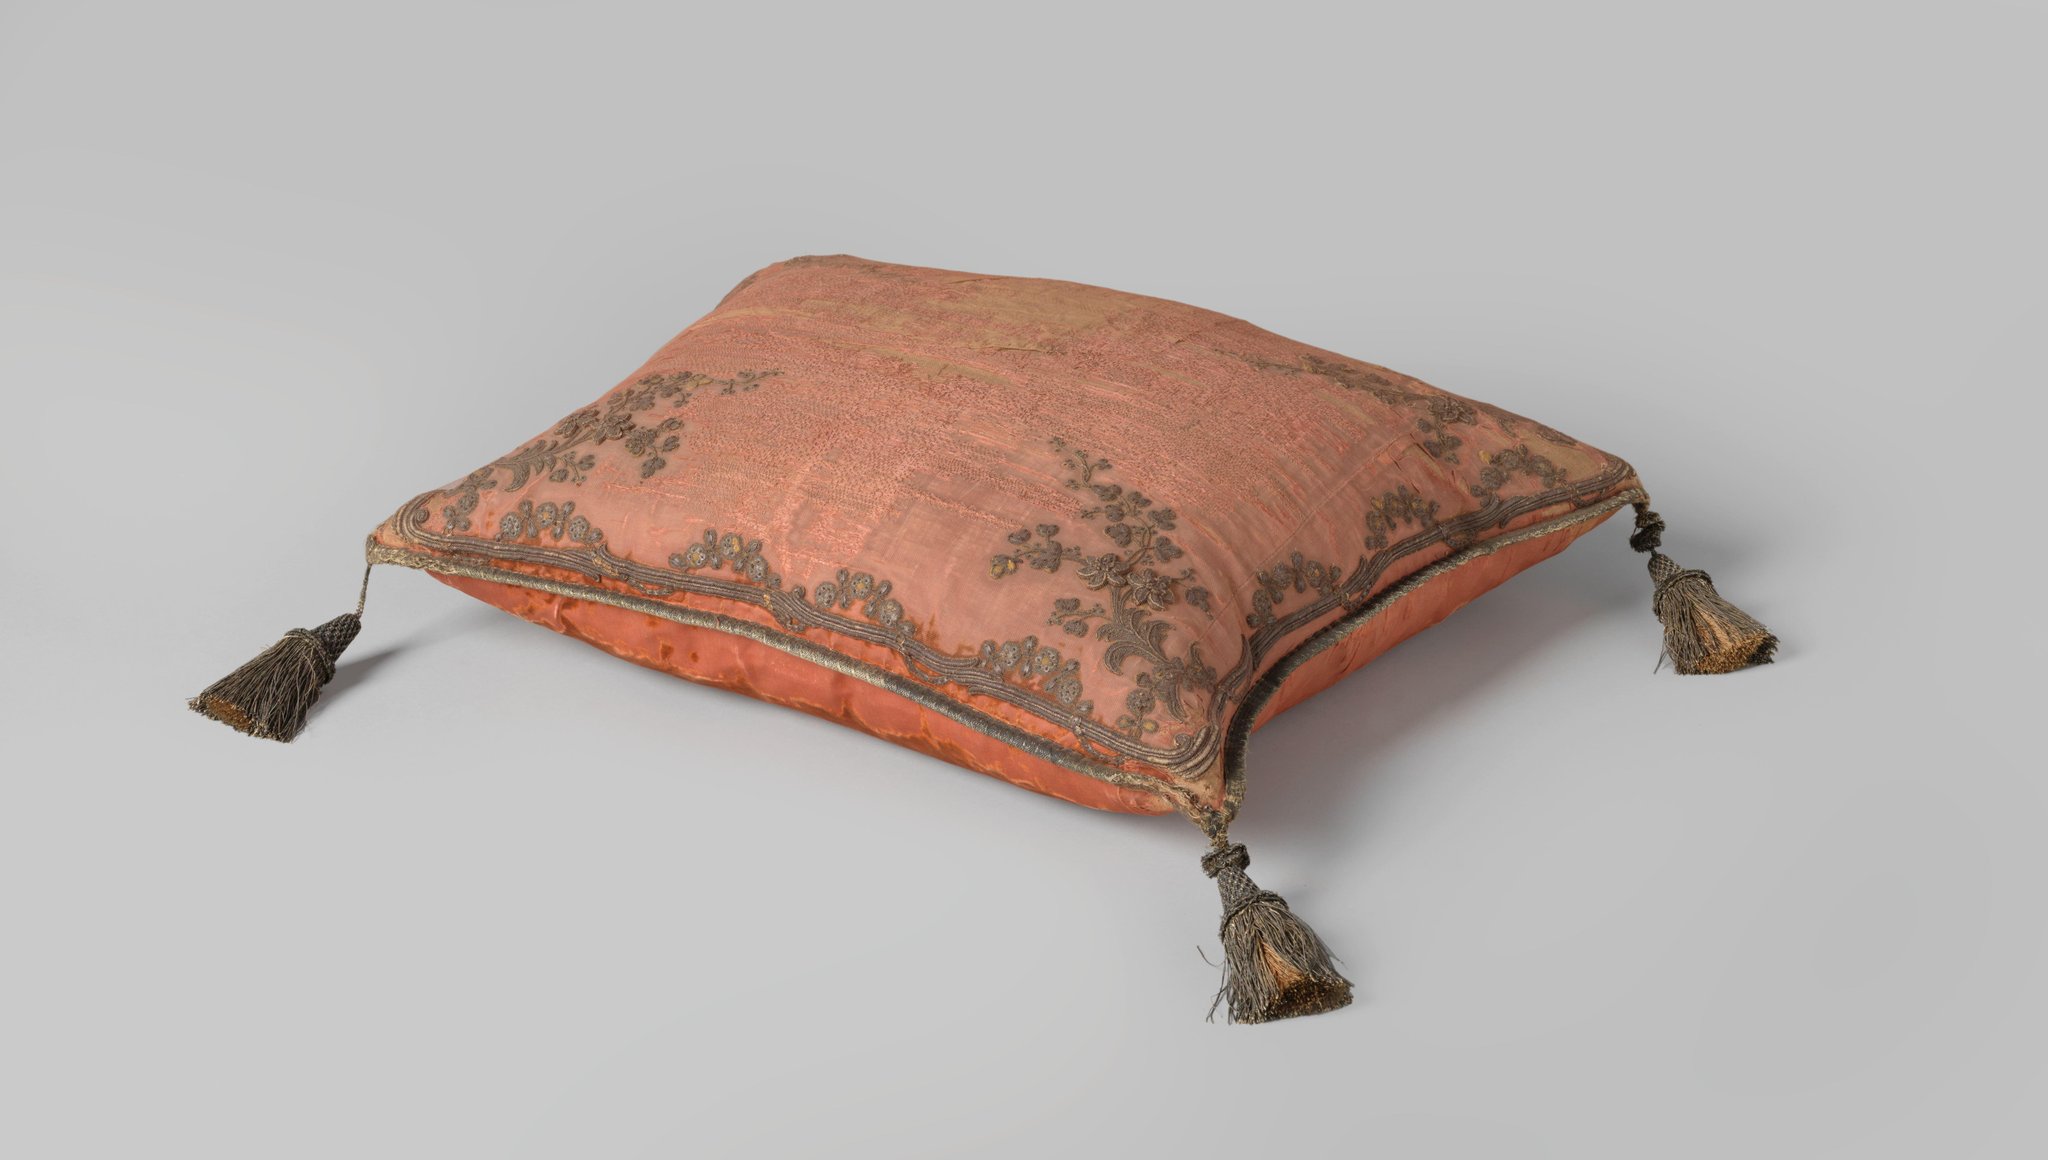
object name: stoelkussen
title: Kussen van stadhoudersstoel met wapen van provincie Groningen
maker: Anonymous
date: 1755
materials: thread, velvet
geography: northern netherlands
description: Kussen van rood fluweel, waarop geborduurd een bloemkrans van zilverdraad. Op de hoeken kwasten van zilverdraad. Horend bij een stadhoudersstoel (inv.nr. BK-NM-1138).